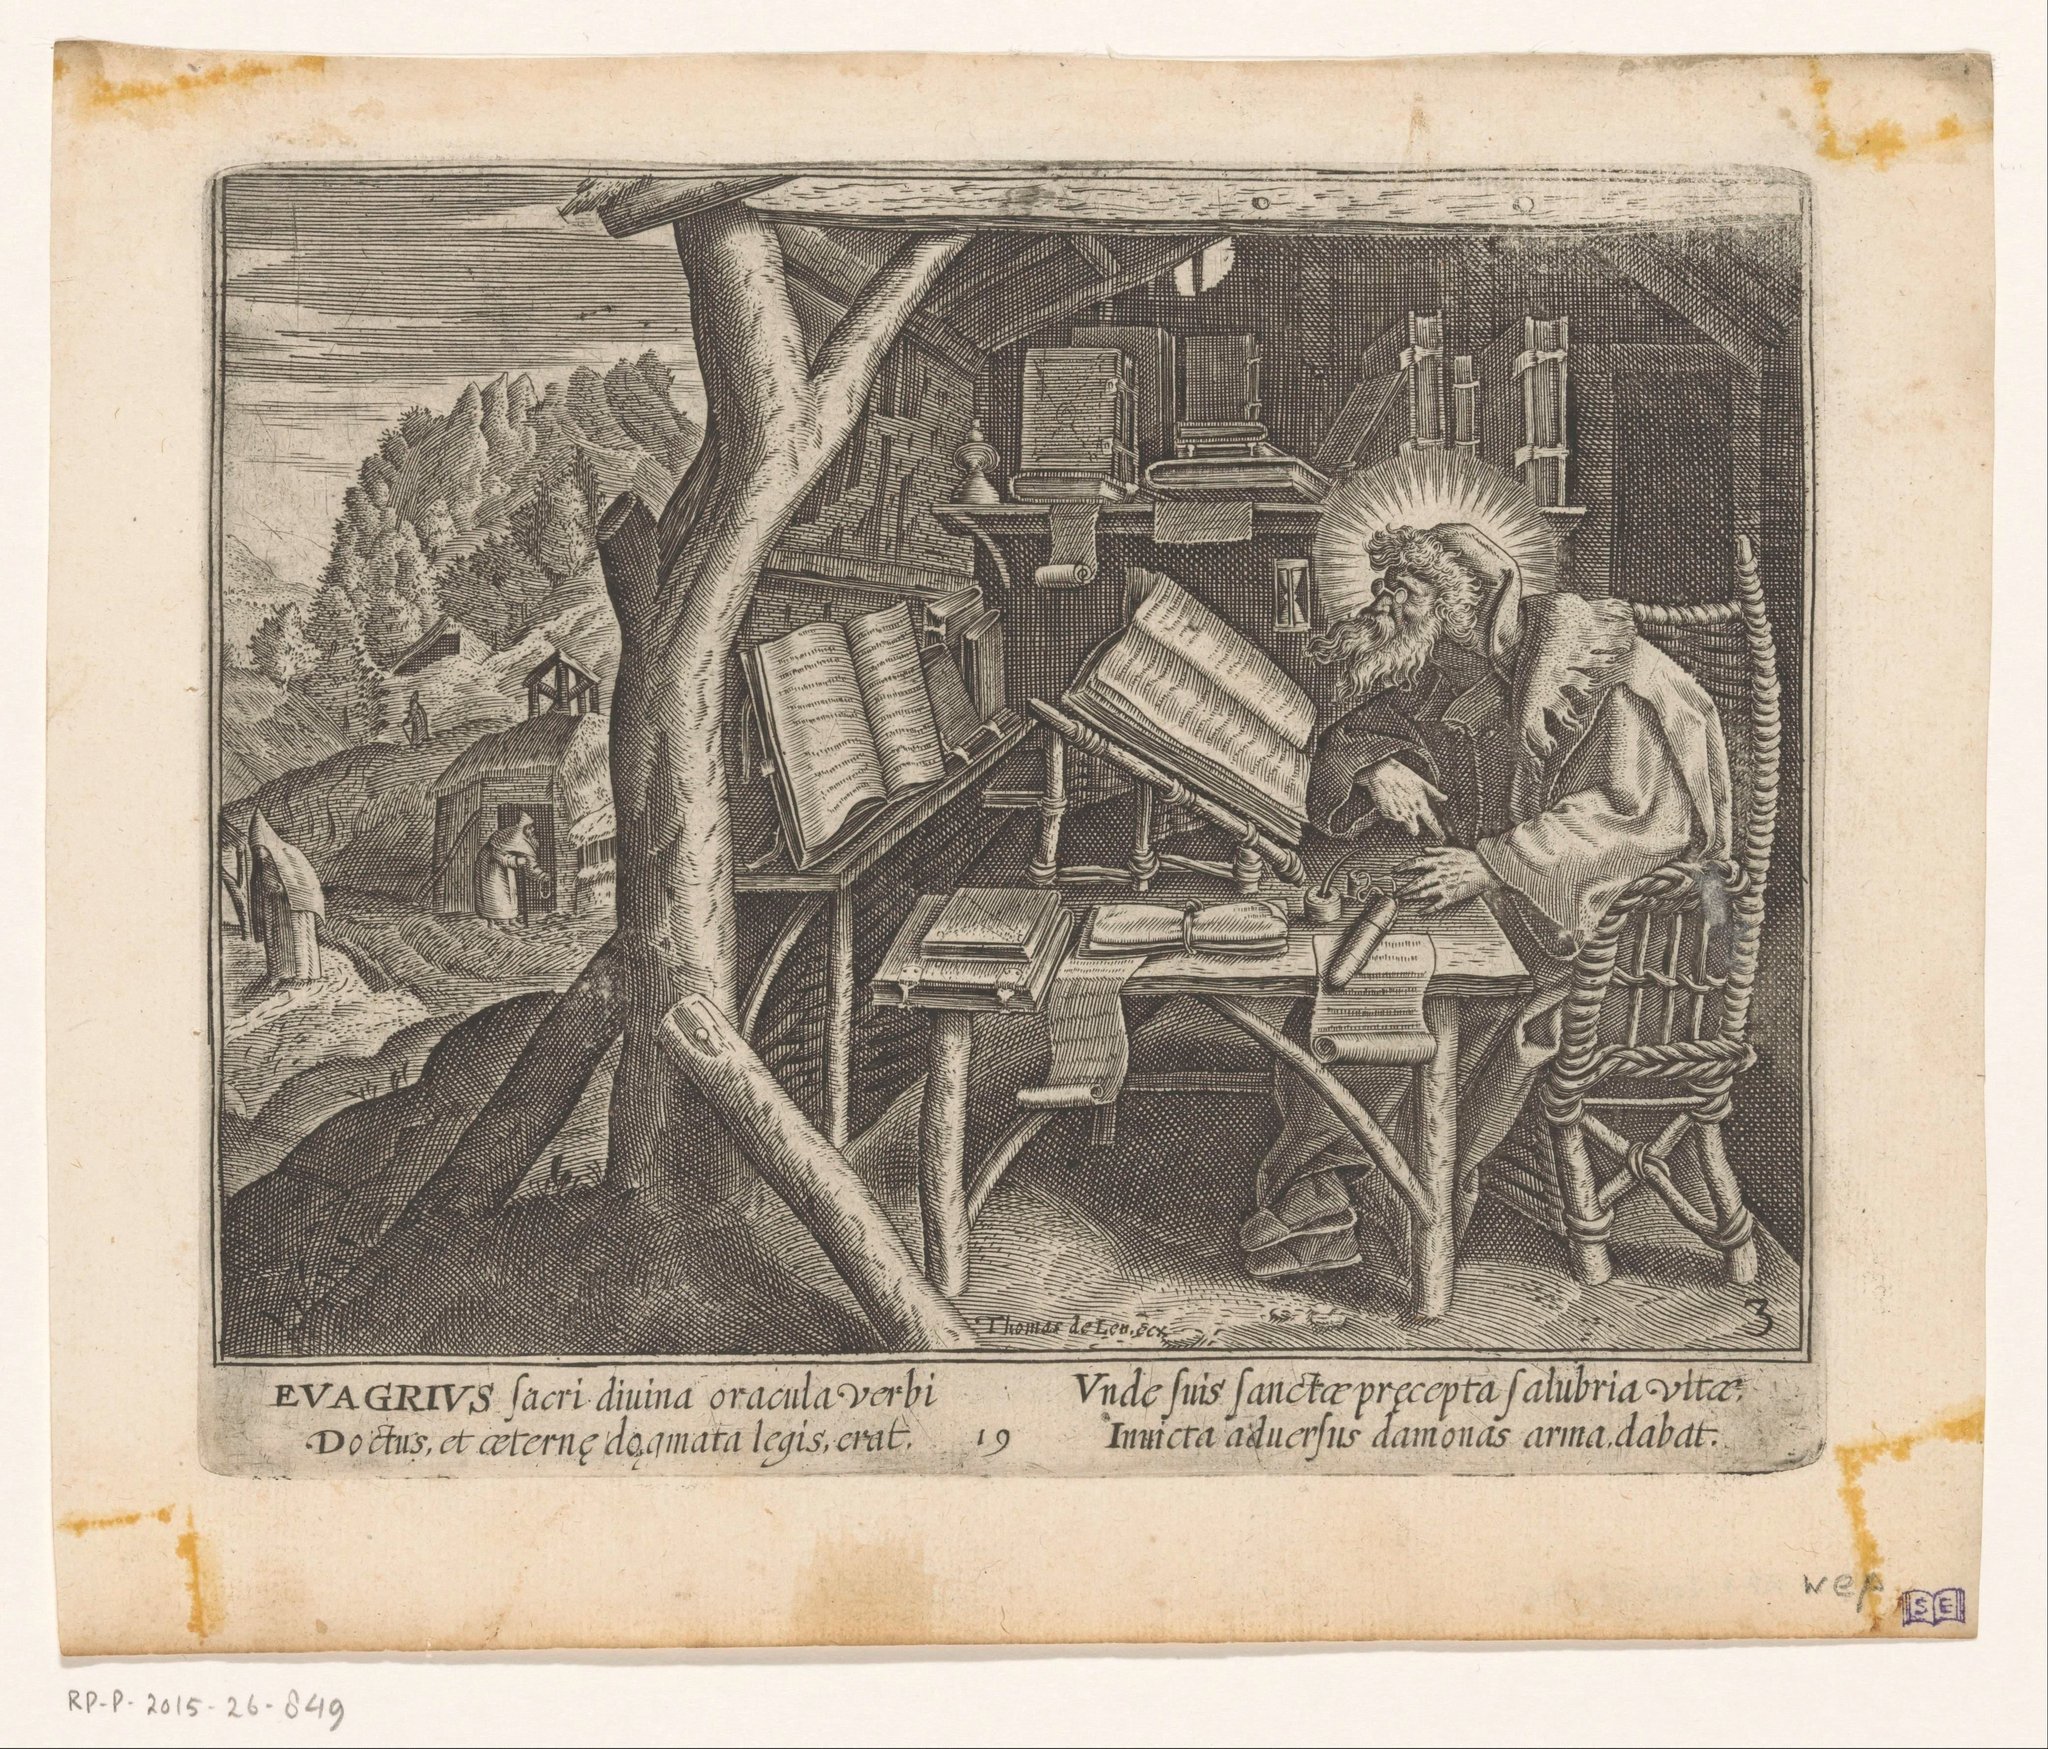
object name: print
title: Mannelijke kluizenaars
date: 1606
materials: paper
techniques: engraving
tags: male saints (with name), anchorite, hermit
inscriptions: collector's mark: Lugt 2228, collector's mark: Lugt 4780, collector's mark: Lugt 4779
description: De H. Evagrius Ponticus als kluizenaar in een hut. Hij zit voor zijn schrijftafel en leest een boek. Op de achtergrond andere kluizenaars. Middenonder genummerd: 19; rechtsonder genummerd: 3.